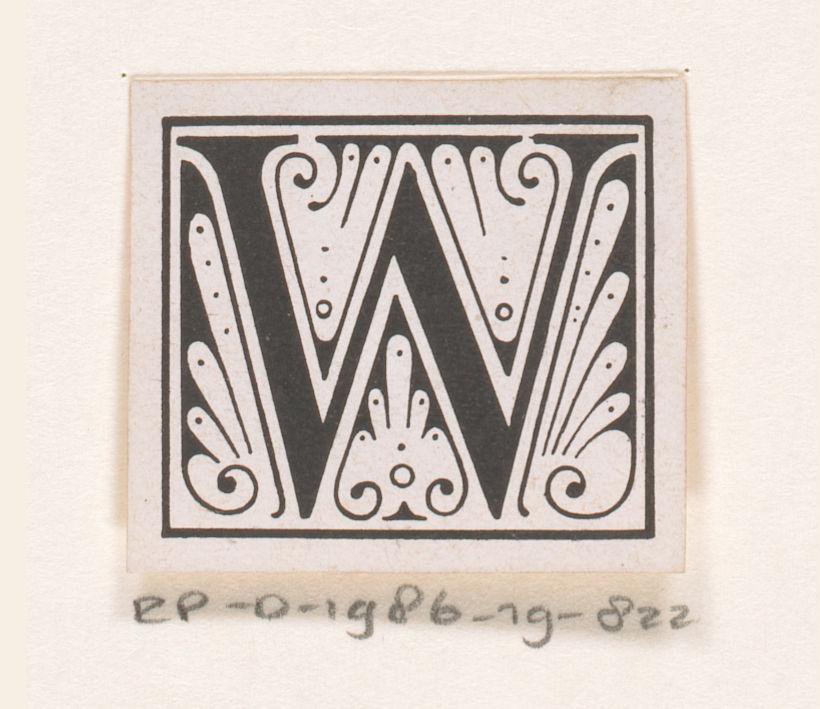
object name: photomechanical print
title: Initiaal W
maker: reinier willem petrus de vries (1874-1953)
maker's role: draughtsman, print maker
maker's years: 1874-1953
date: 1904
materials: paper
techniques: printing block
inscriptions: collector's mark: ‘R:MVS.’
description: Het initiaal is gebruikt voor: Veth, Jan. Jozef Israëls en zijn kunst. Arnhem en Nijmegen: Gebroeders E&M Cohen, 1904.